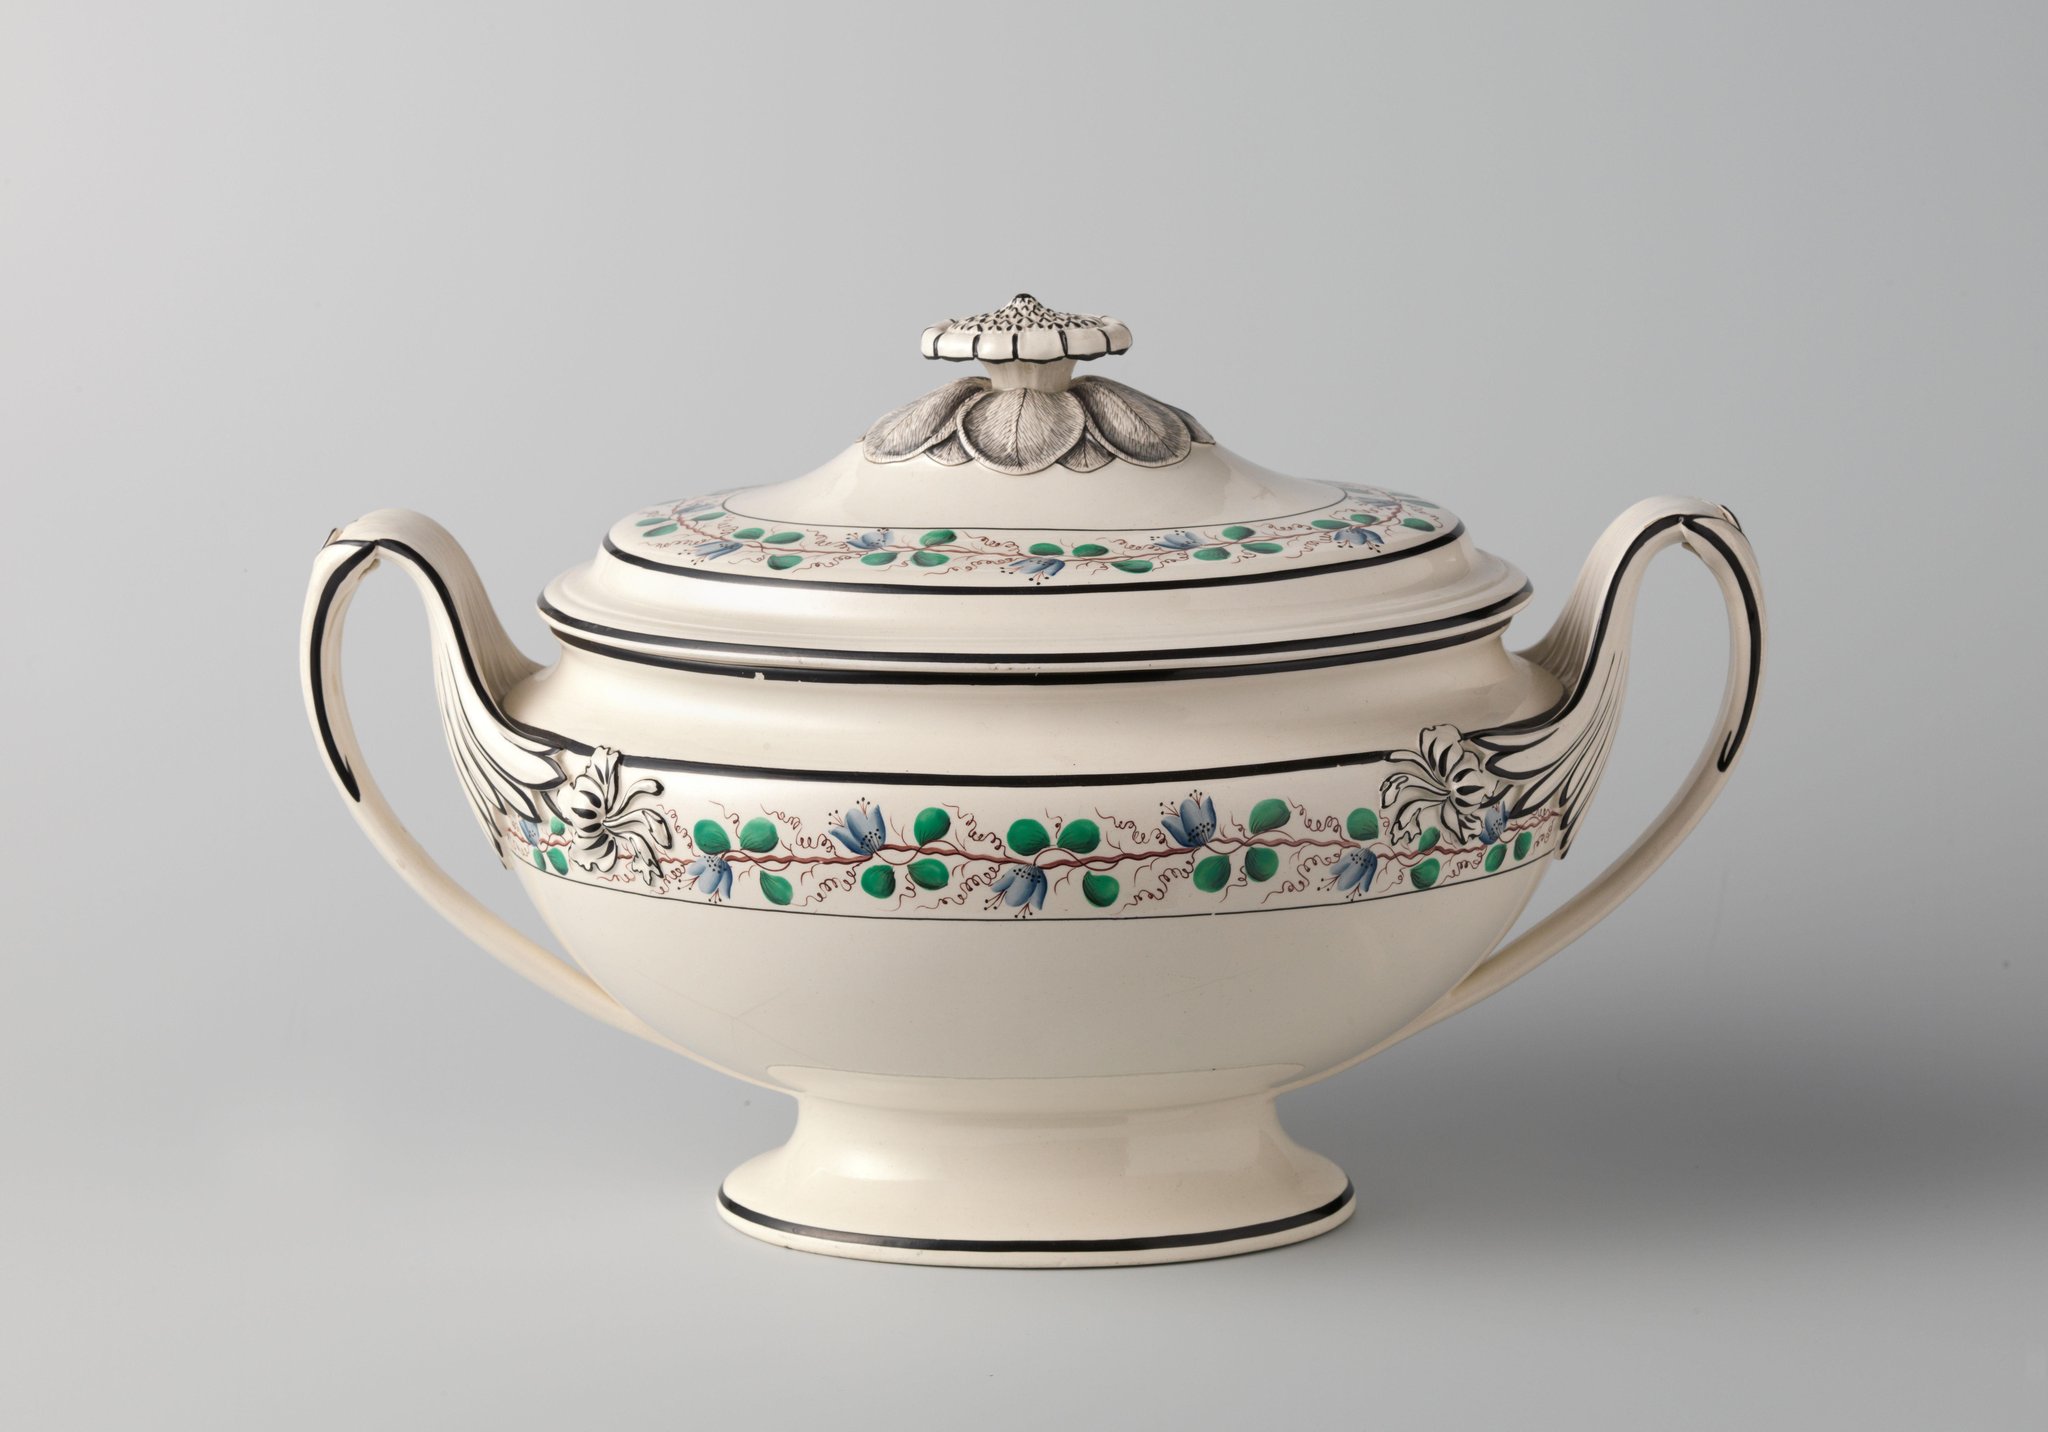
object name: tureen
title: Soepterrine van hardgebakken aardewerk, Wedgood creamware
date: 1770-1780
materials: earthenware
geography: england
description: Soepterrine van hardgebakken aardewerk. De terrine staat op een voet en heeft hoge, C-vormige oren. De bovenkant van de oren heeft de vorm van een (papyrus?) blad dat tegen de terrine aan ligt. Vanuit het blad loopt aan weerszijden van de terrine een bloem in reliëf. De terrine is beschilderd met zwarte lijnen en een rank met bloemen en vruchten. De terrine is gemerkt: Wedgwood.